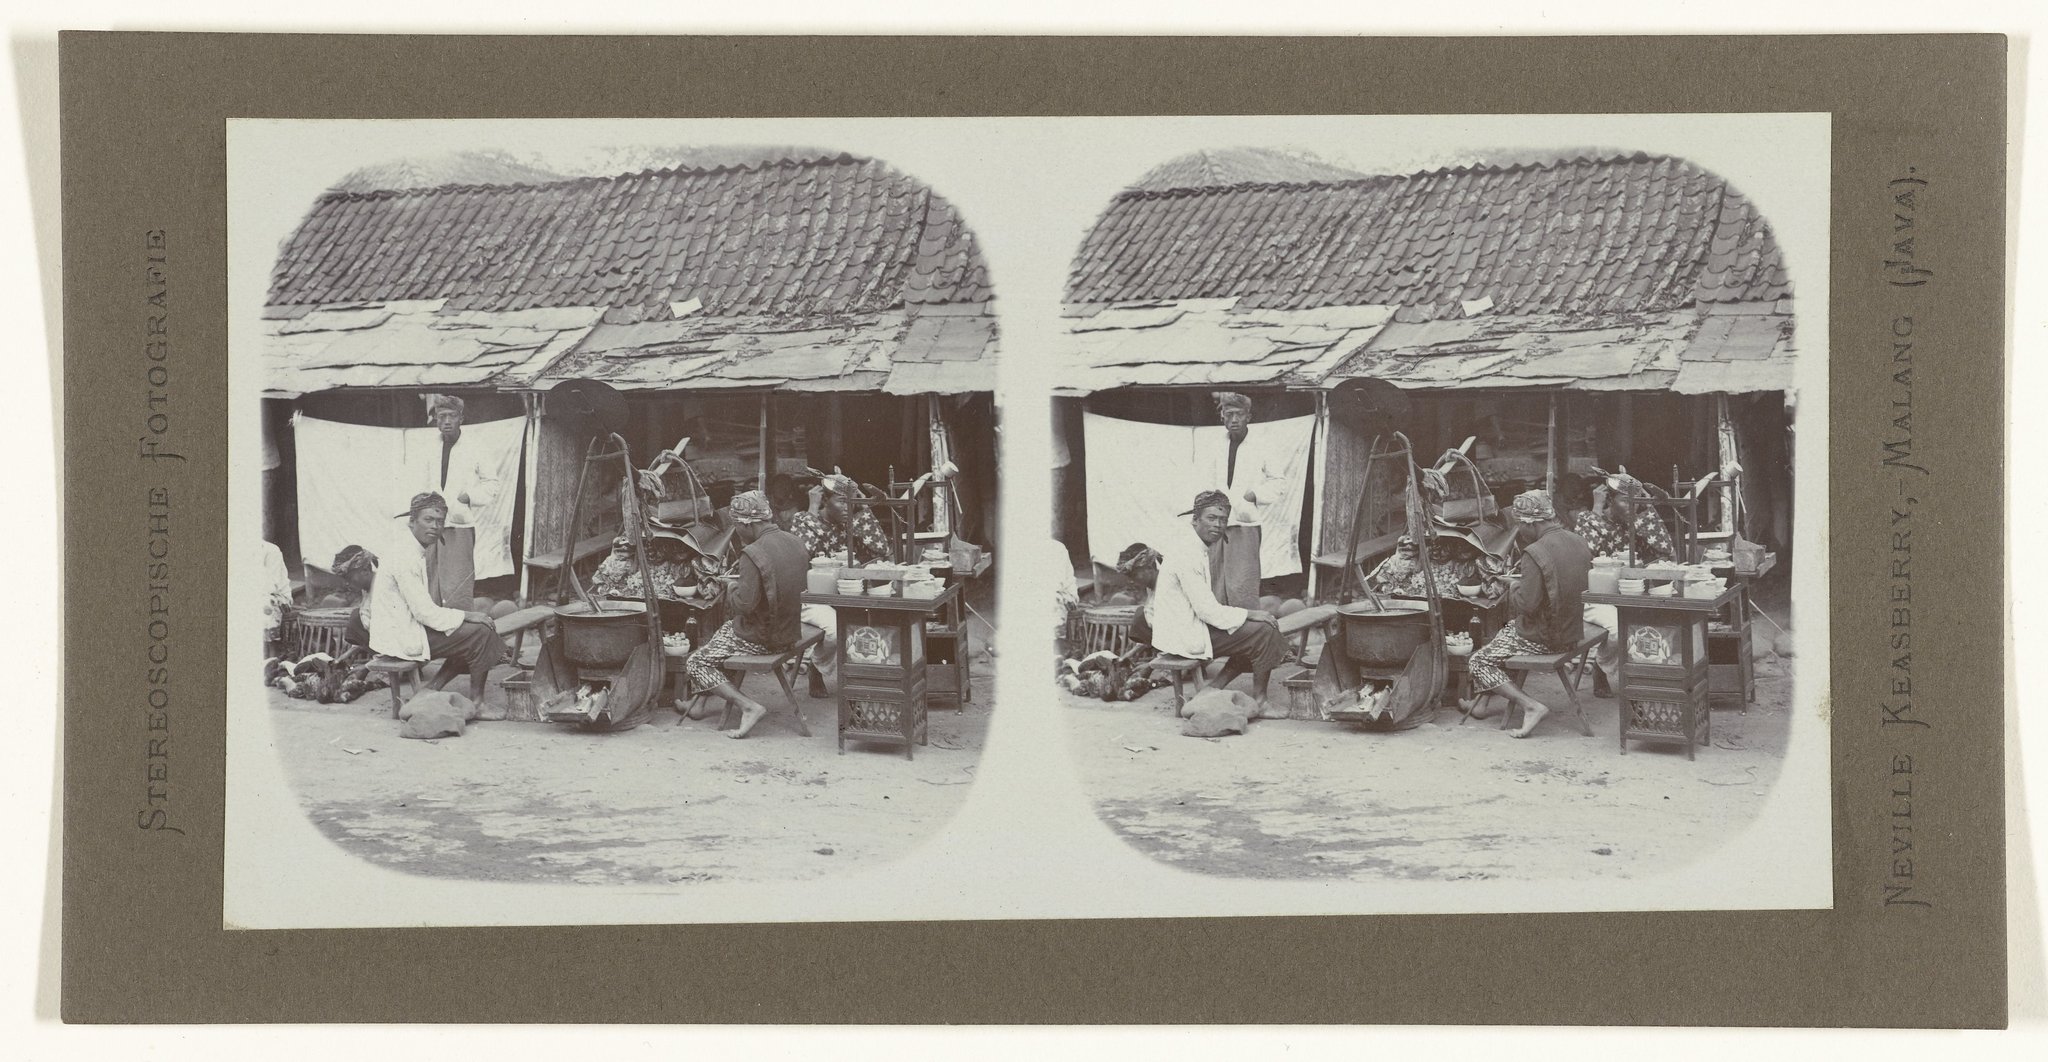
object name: photograph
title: S 8 No 87. Passer-typen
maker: neville keasberry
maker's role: fotograaf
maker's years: 1866-1944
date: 1900-1935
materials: cardboard, paper, photographic support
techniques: albumen print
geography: malang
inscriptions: signature: ‘Neville Keasberry, Malang (Java)’, inscription: ‘Stereoscopische Fotografie’